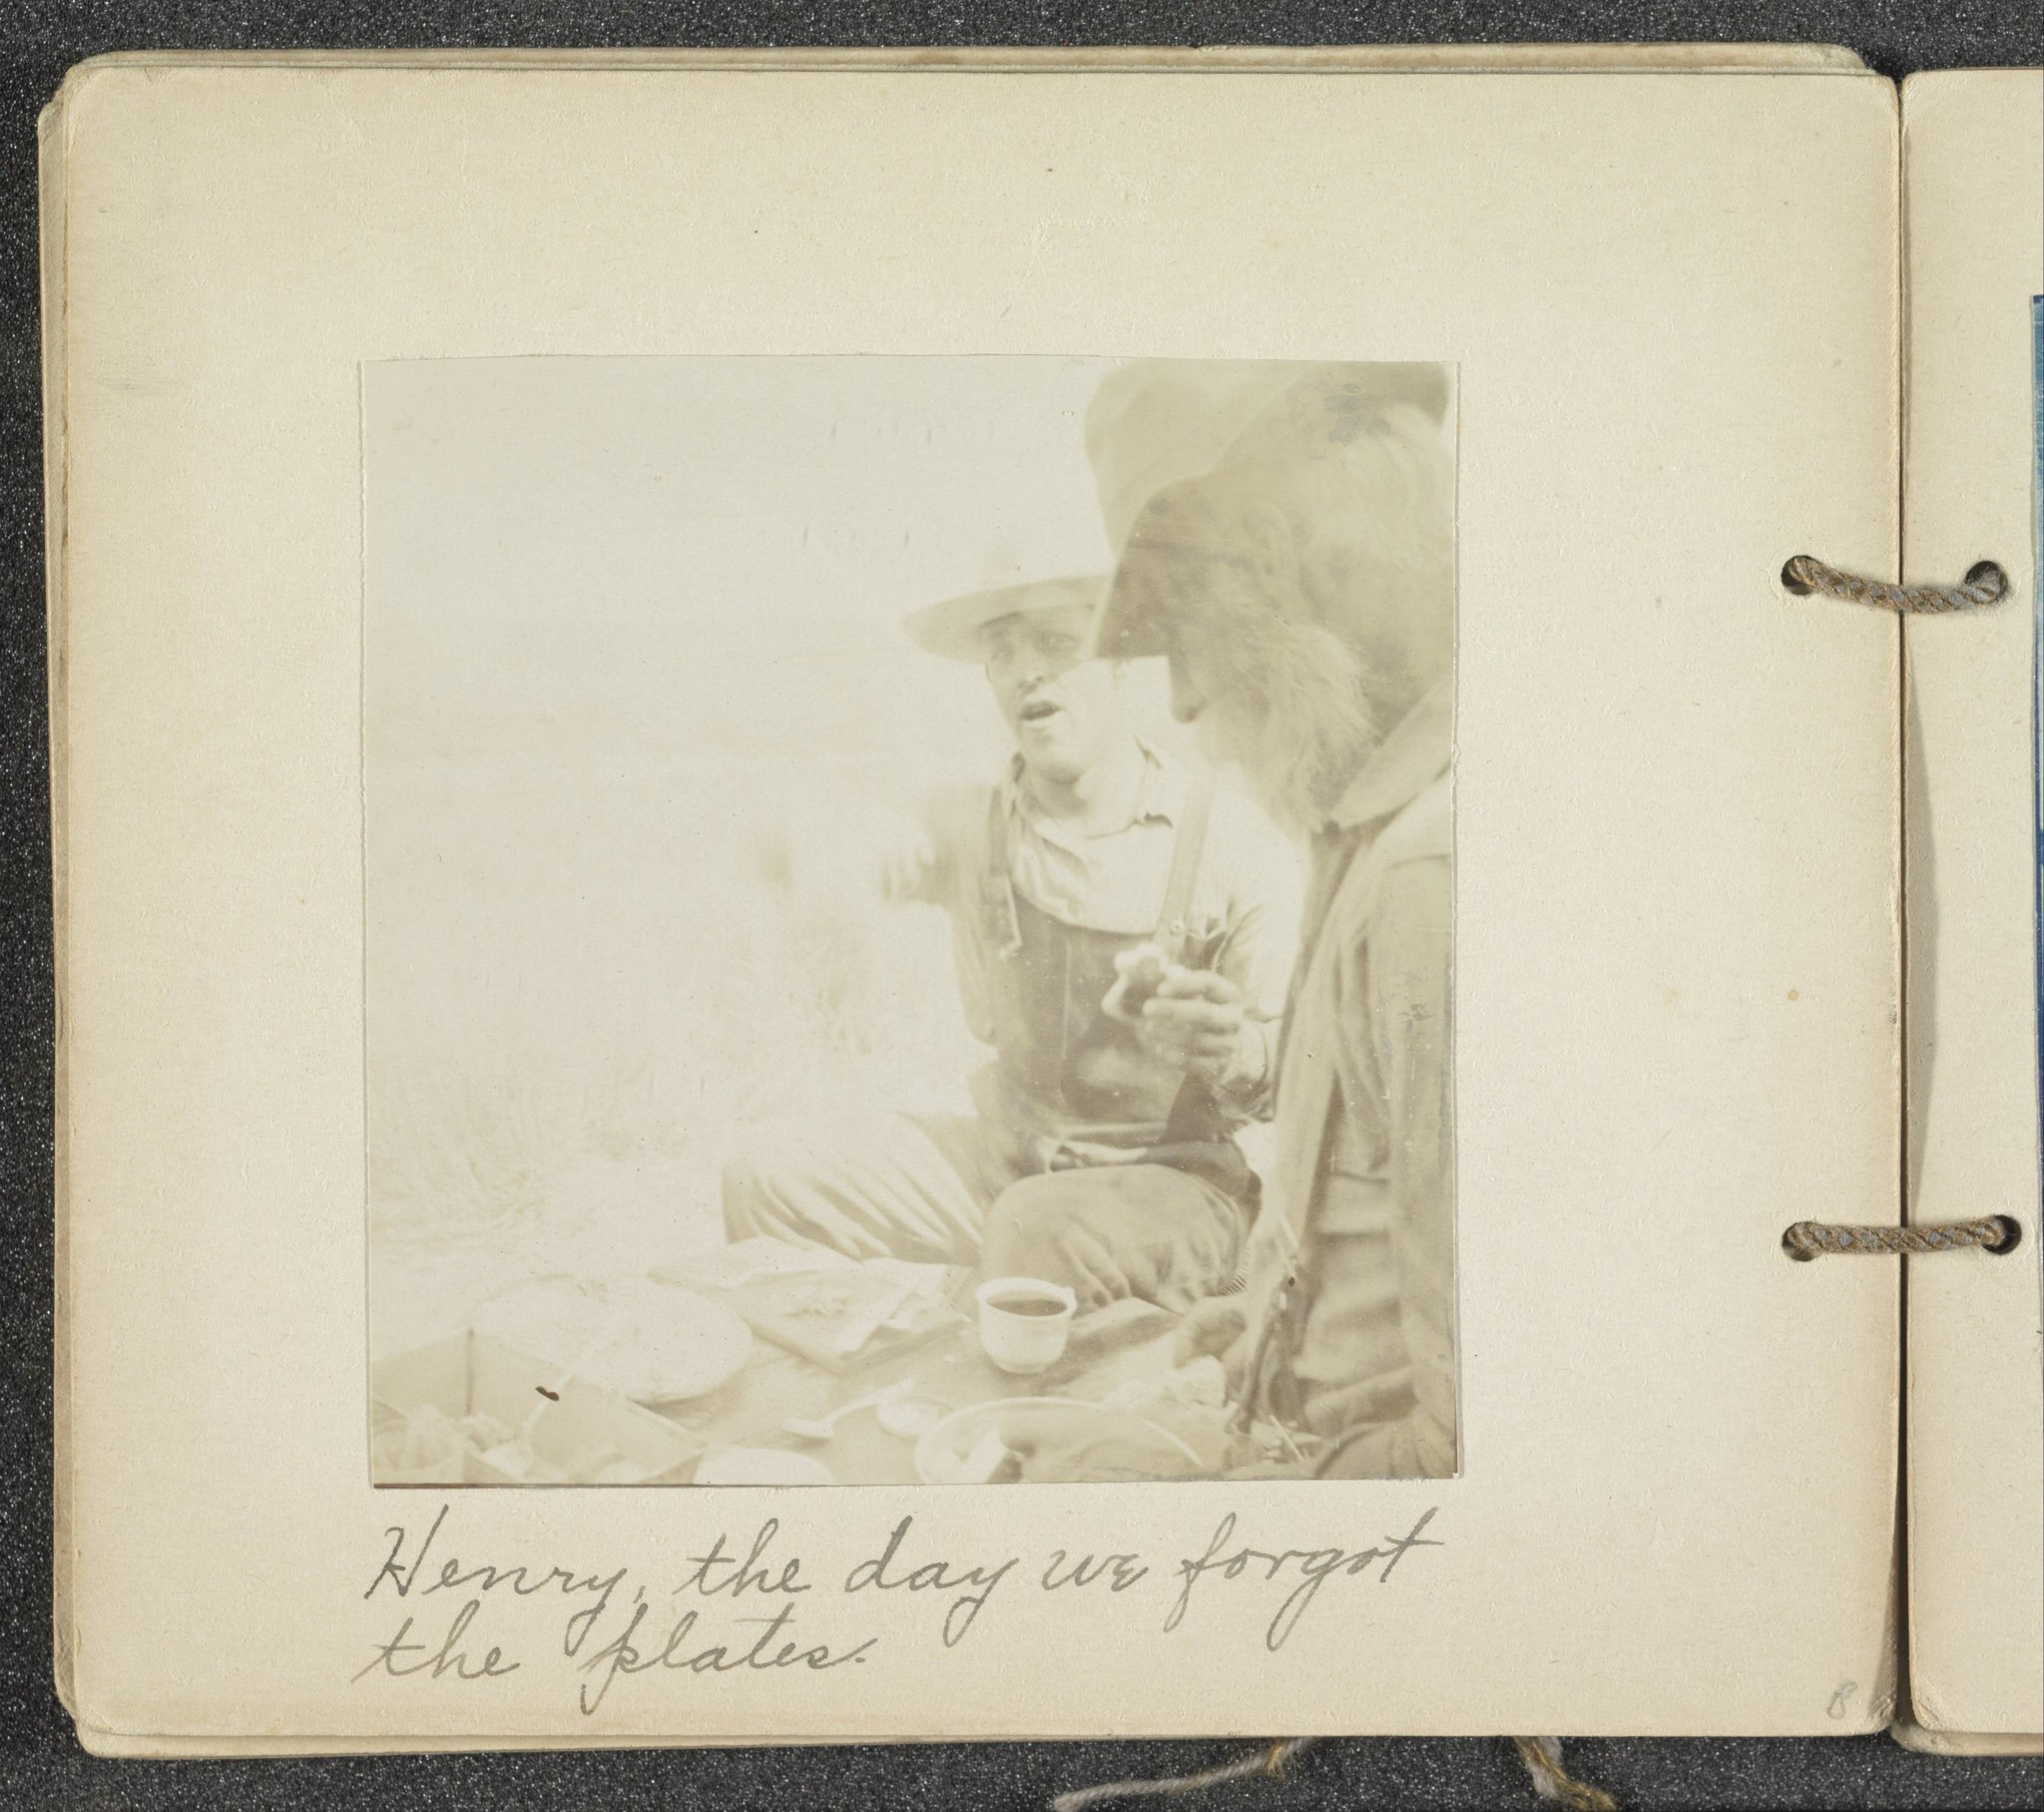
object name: photograph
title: Boeren aan de maaltijd op het veld tijdens de oogst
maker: Anonymous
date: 1905-1920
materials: paper, photographic support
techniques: gelatin silver print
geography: united states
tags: harvest, farmers, eating and drinking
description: Onderdeel van Fotoalbum met opnames van oogstende boeren in de Verenigde Staten.